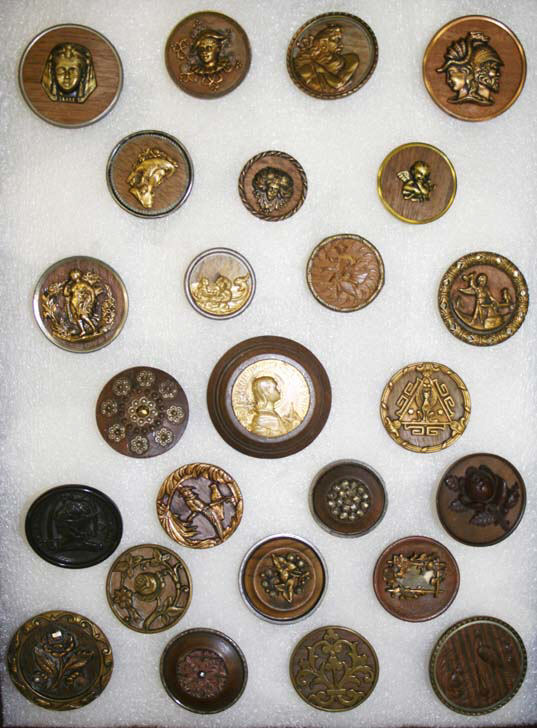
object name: button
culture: british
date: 1880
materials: metal, wood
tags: human figures,birds